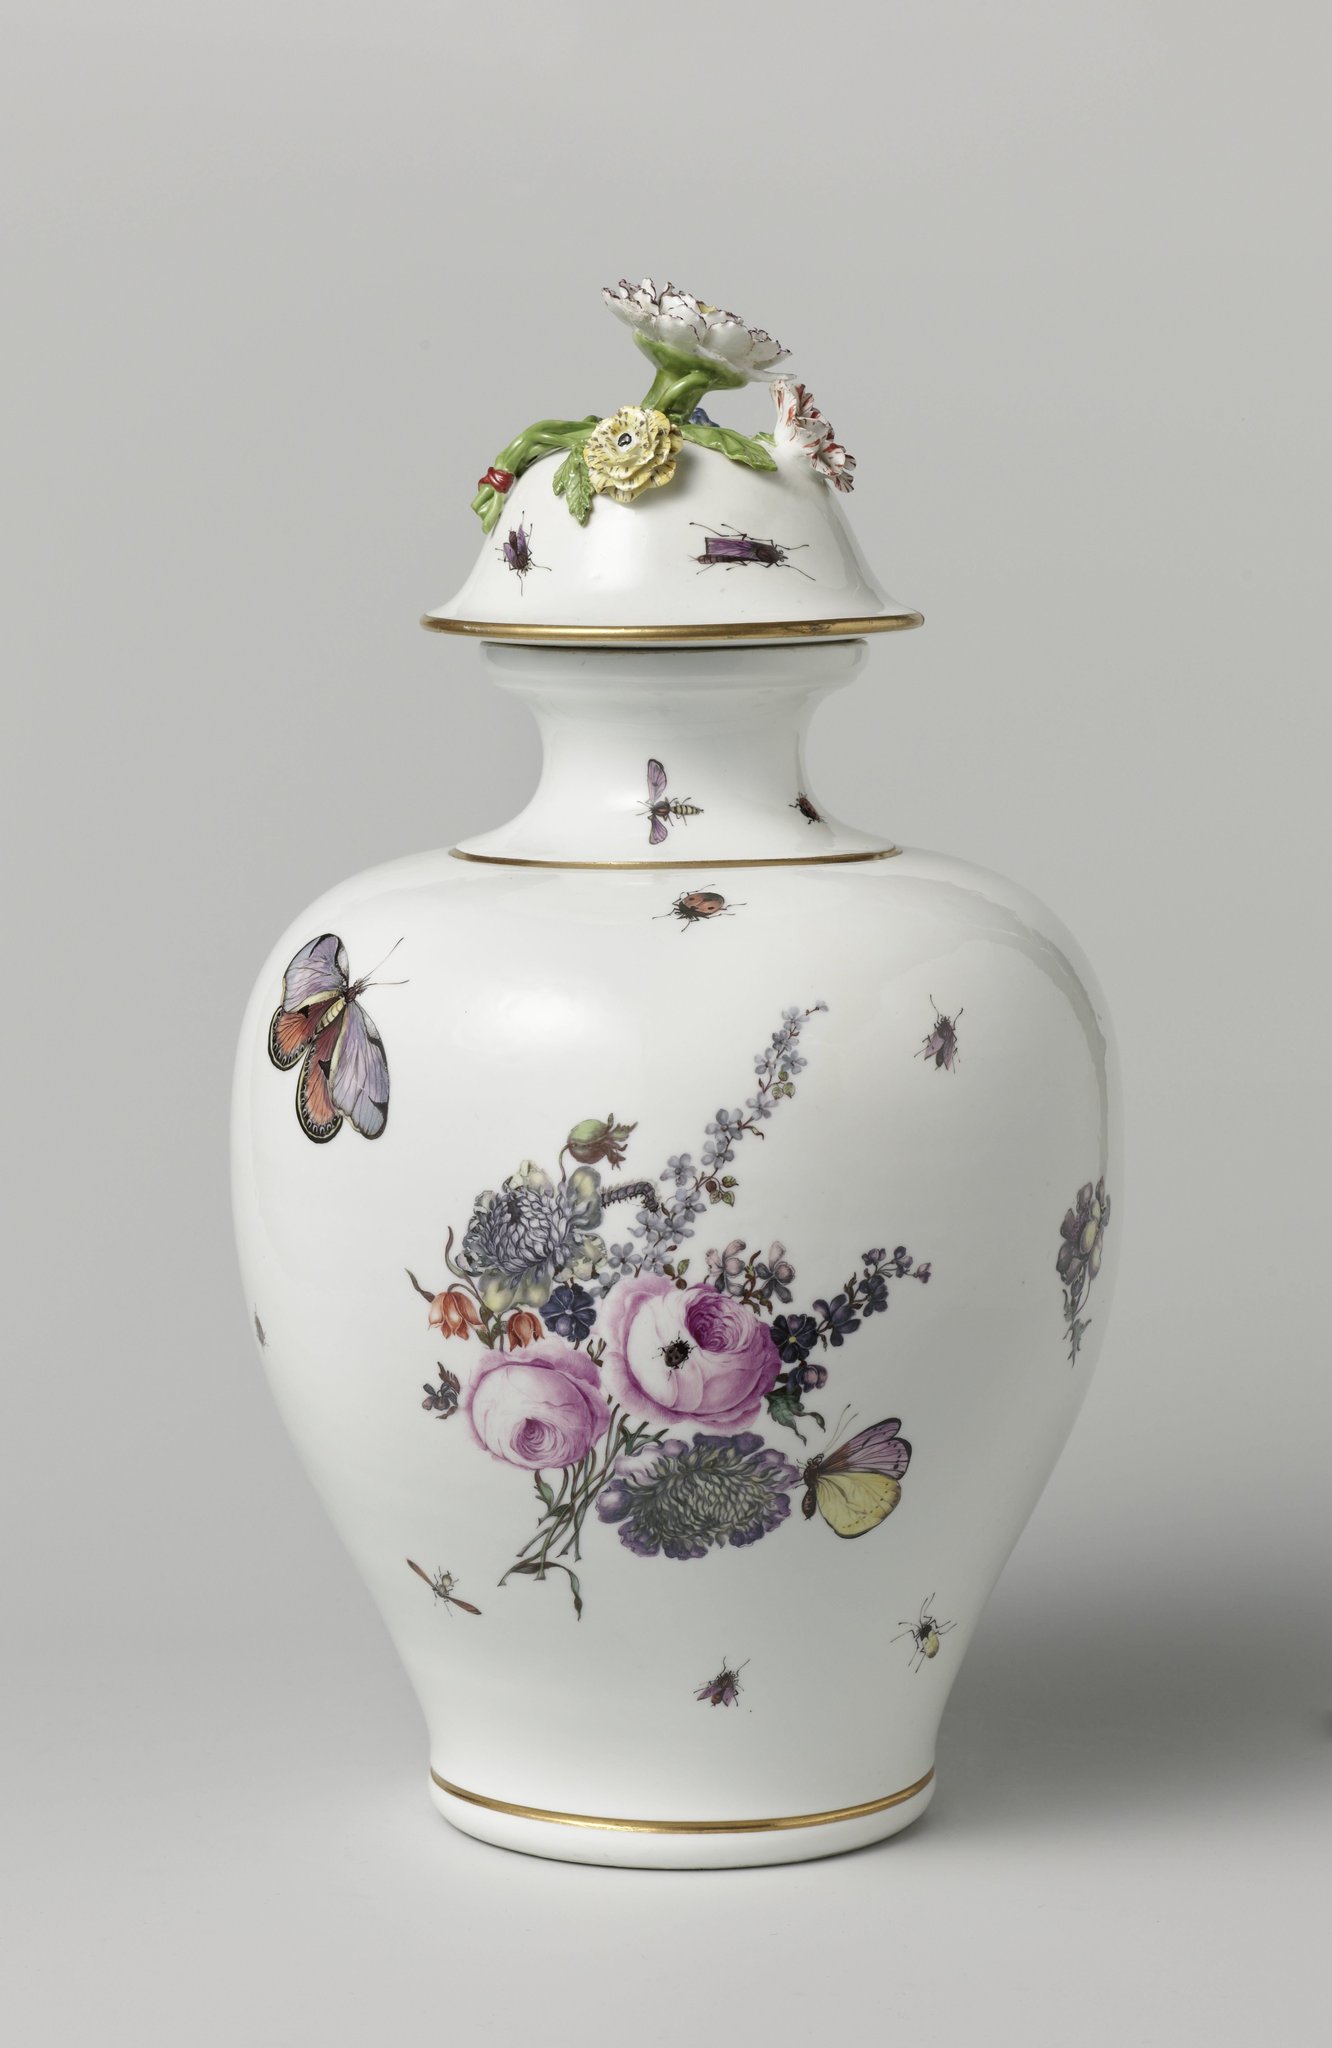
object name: vase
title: Lidded vase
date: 1740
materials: porcelain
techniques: painted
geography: meissen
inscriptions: factory mark, mold mark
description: Meissener Porzellan Manufaktur Meissen, c. 1740 hard-paste porcelain